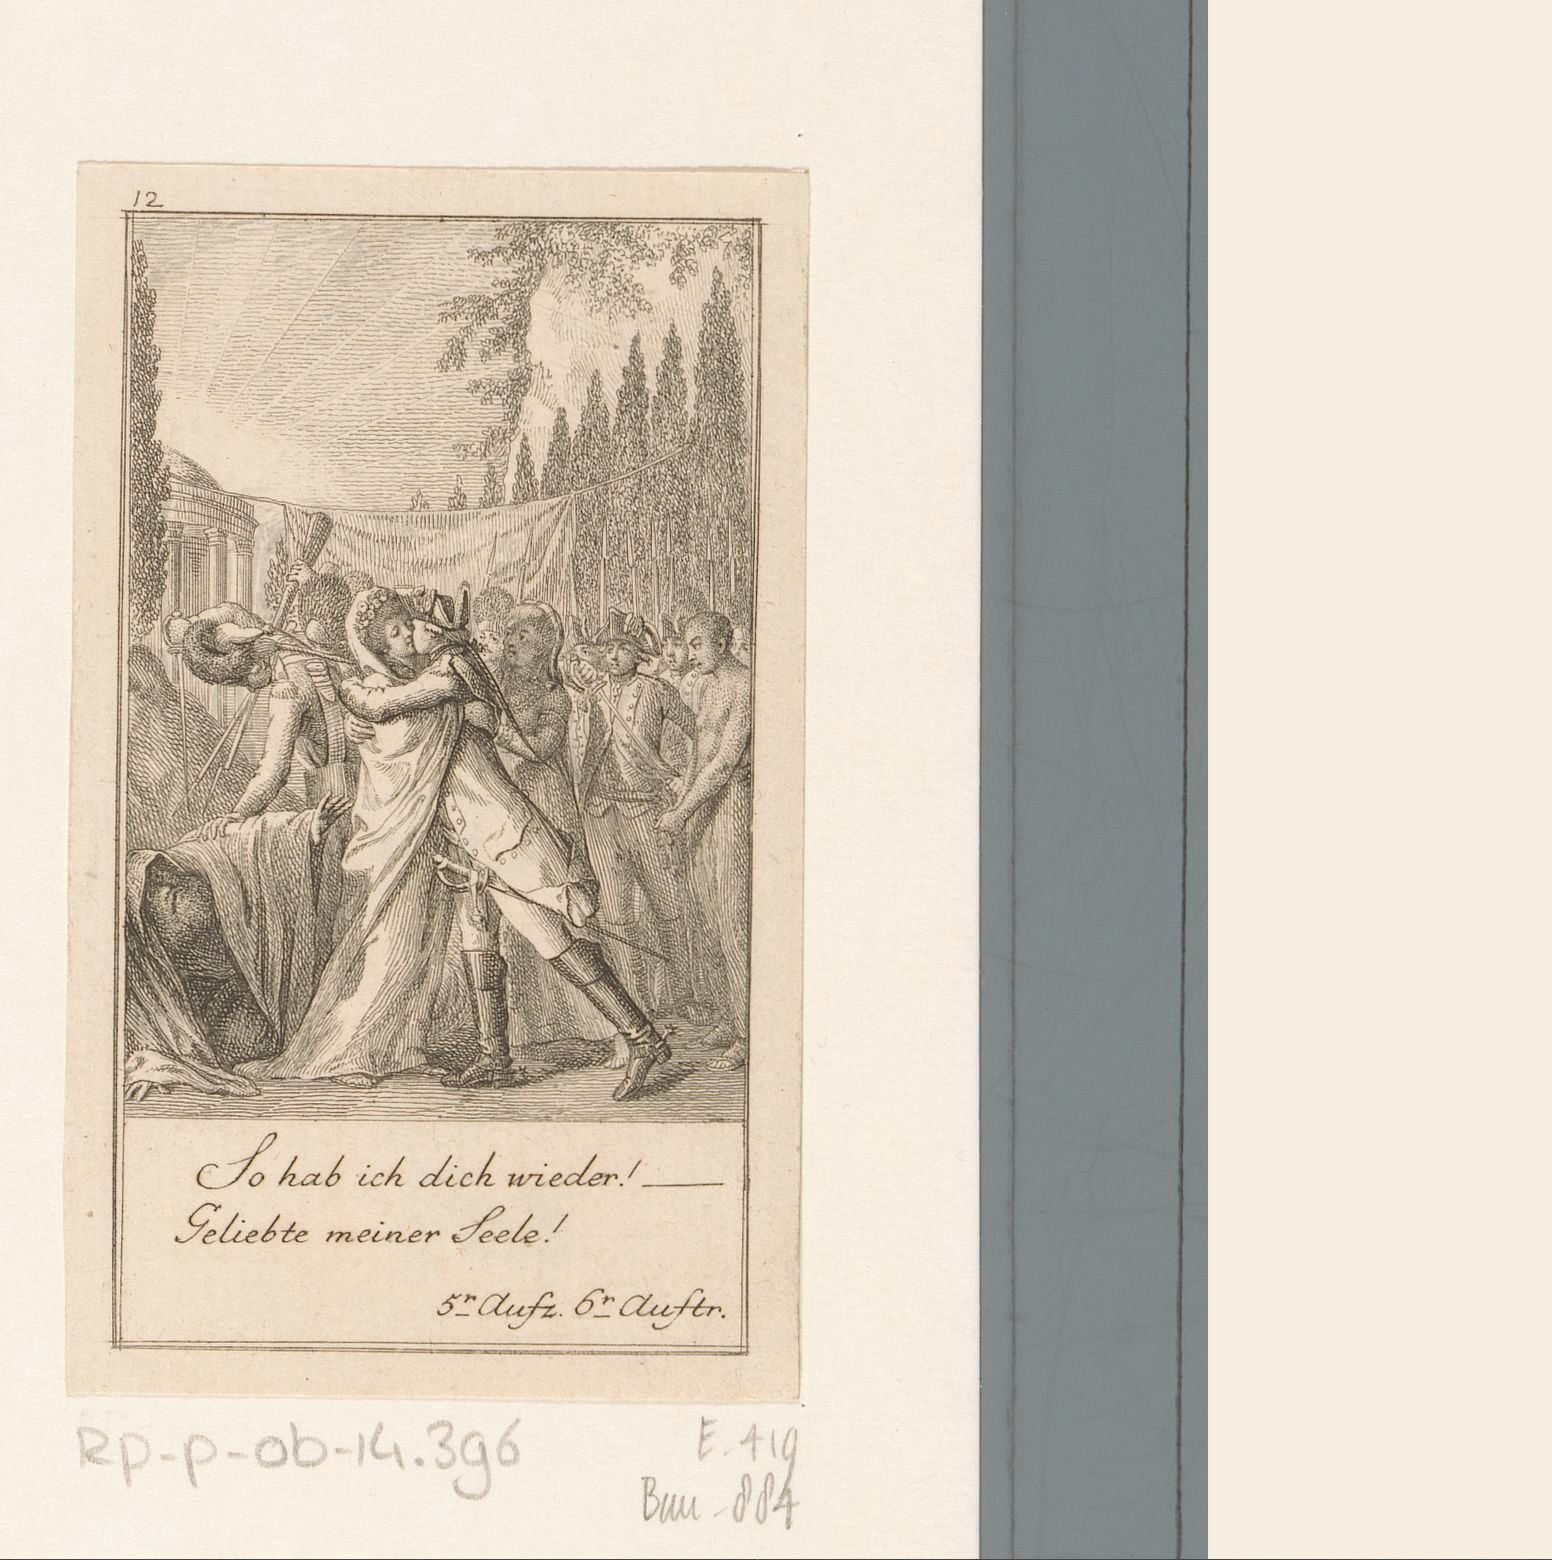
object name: book illustration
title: Lanassa wordt gered door de doodgewaande generaal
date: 1782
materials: paper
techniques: etching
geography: berlin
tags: trees: cypress, literature, embracing each other, kissing, priest ~ non-christian religions, temple, shrine ~ non-christian religions, killing ~ aggressive relationships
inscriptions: collector's mark: Lugt 2228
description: Vervaardigd voor Karl Martin Plümicke's 'Lanassa'. Prent gebruikt voor: Köningl. Grosbr. Genealogischer Kalender auf das 1783 Jahr. Lauenburg: J. G. Berenberg, 1782.